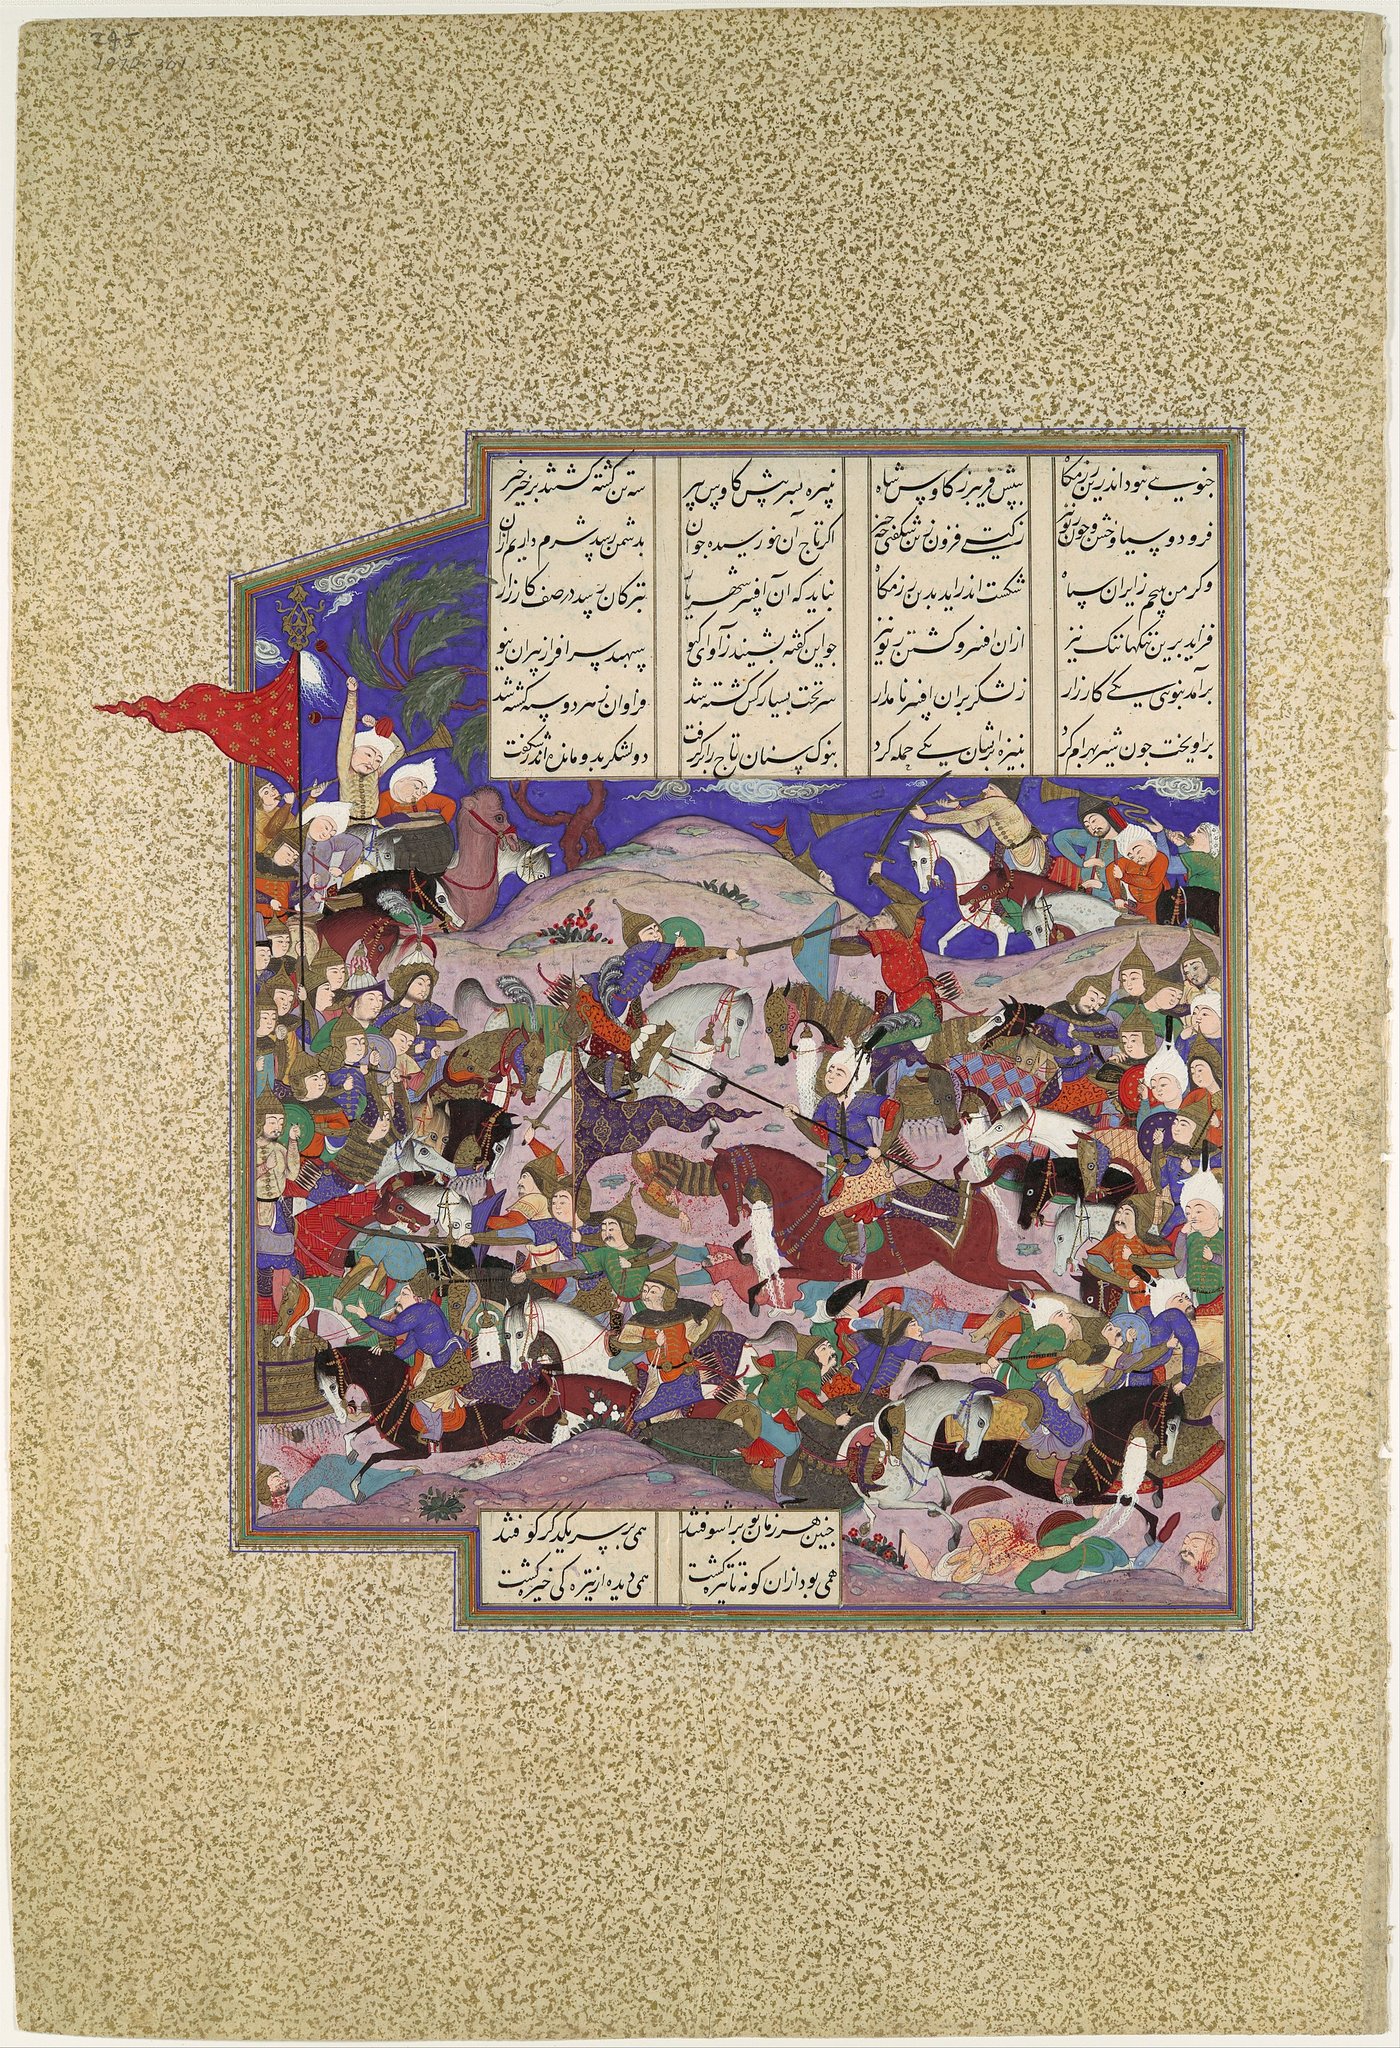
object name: folio from an illustrated manuscript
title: "Bahram Recovers the Crown of Rivniz", Folio 245r from the Shahnama (Book of Kings) of of Abu'l Qasim Firdausi, commissioned by Shah Tahmasp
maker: abu'l qasim firdausi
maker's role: author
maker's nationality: iranian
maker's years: 935-1020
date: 1525-1530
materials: gold, ink, paper, silver, watercolor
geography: iran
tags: battles,men,horses